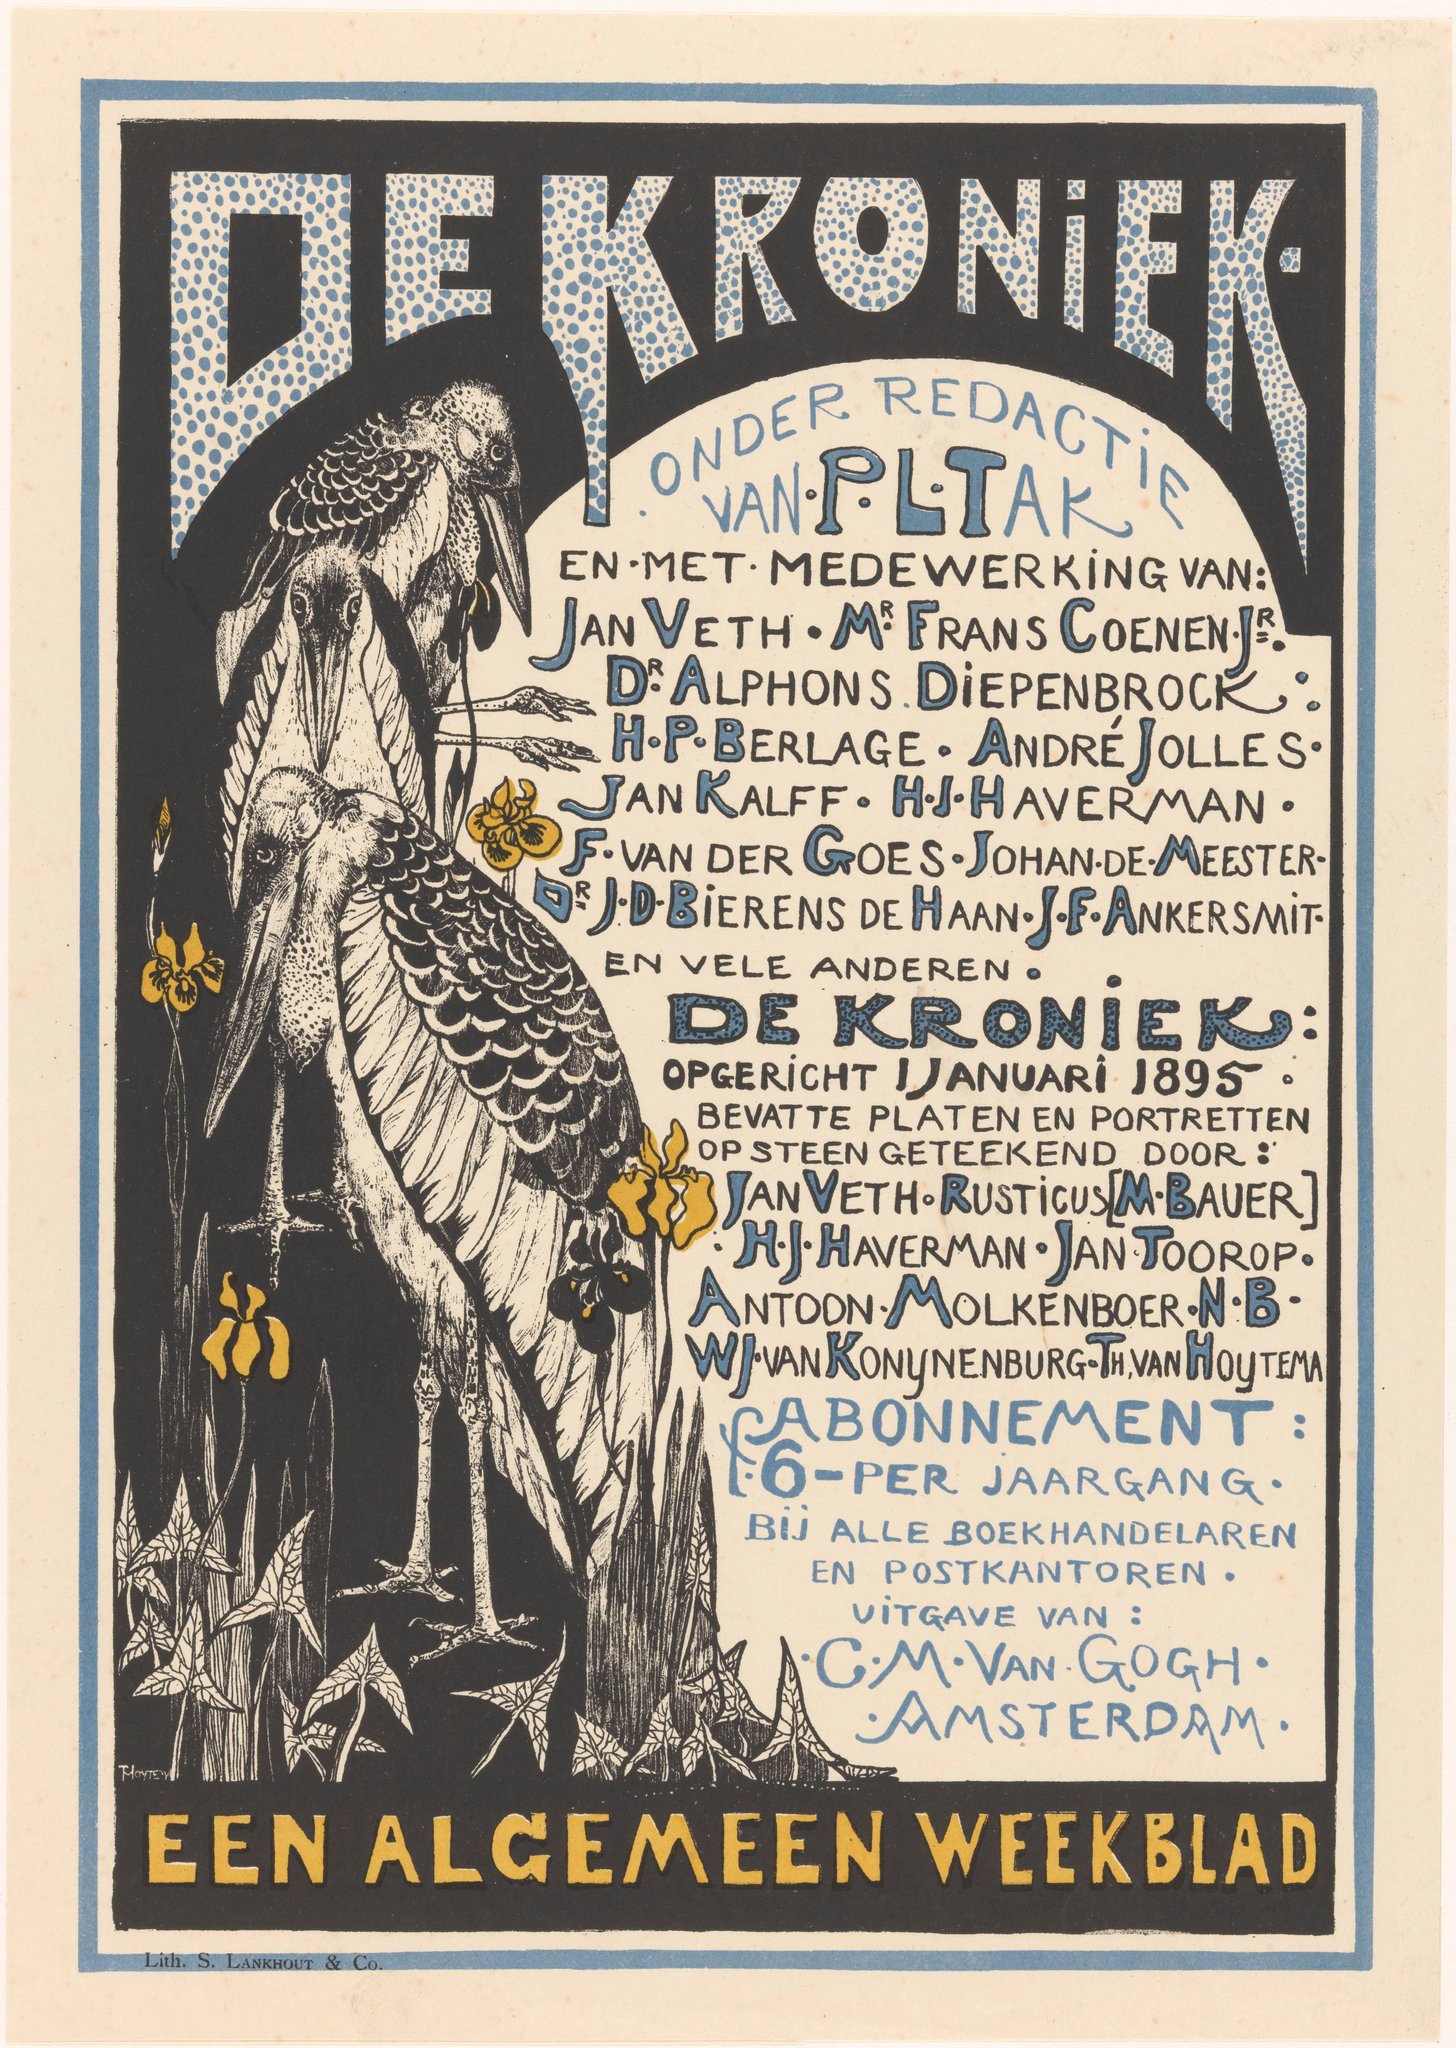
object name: advertising card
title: Reclamekaart voor 'De Kroniek'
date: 1895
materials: paper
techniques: letterpress printing, lithograph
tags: shore-birds and wading-birds: marabou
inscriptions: collector's mark: Lugt 2233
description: Links naast de tekst drie maraboes tussen lelies en waterplanten.